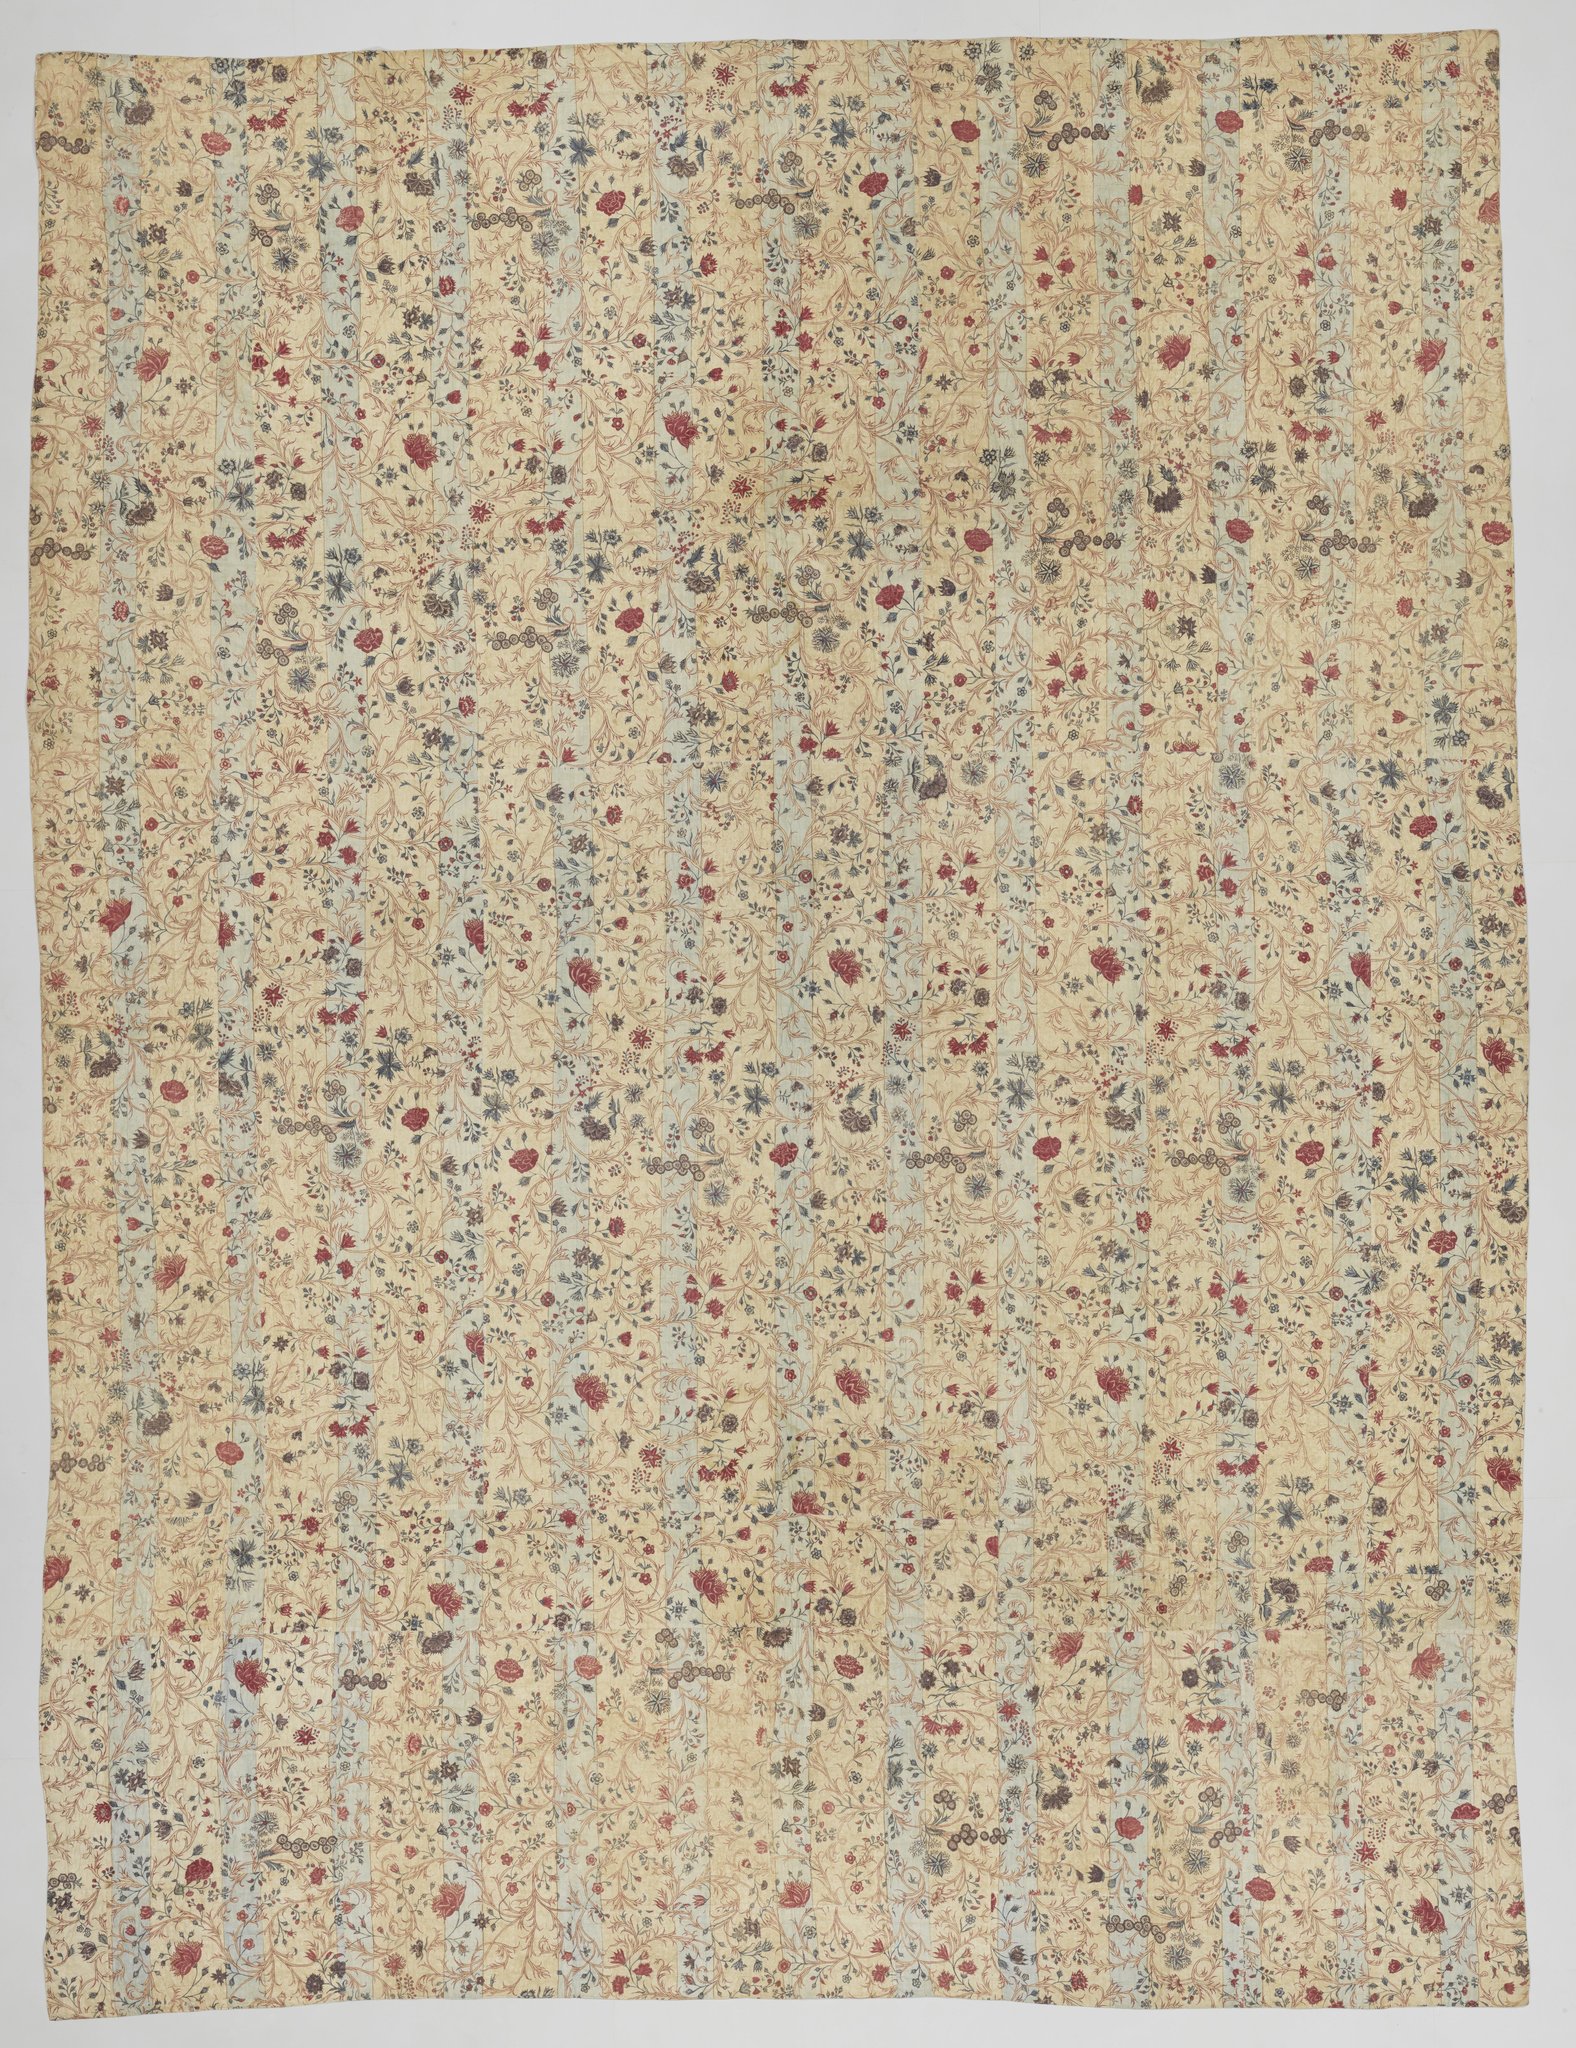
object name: bedspread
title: Doorgestikte sitsen sprei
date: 1600-1980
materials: textile, cotton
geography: east indies